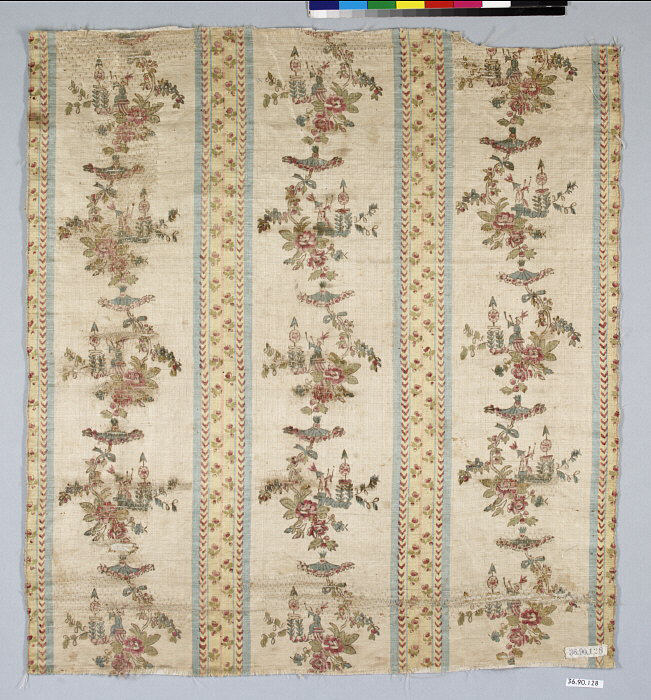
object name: piece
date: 1701-1800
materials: silk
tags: flowers,leaves